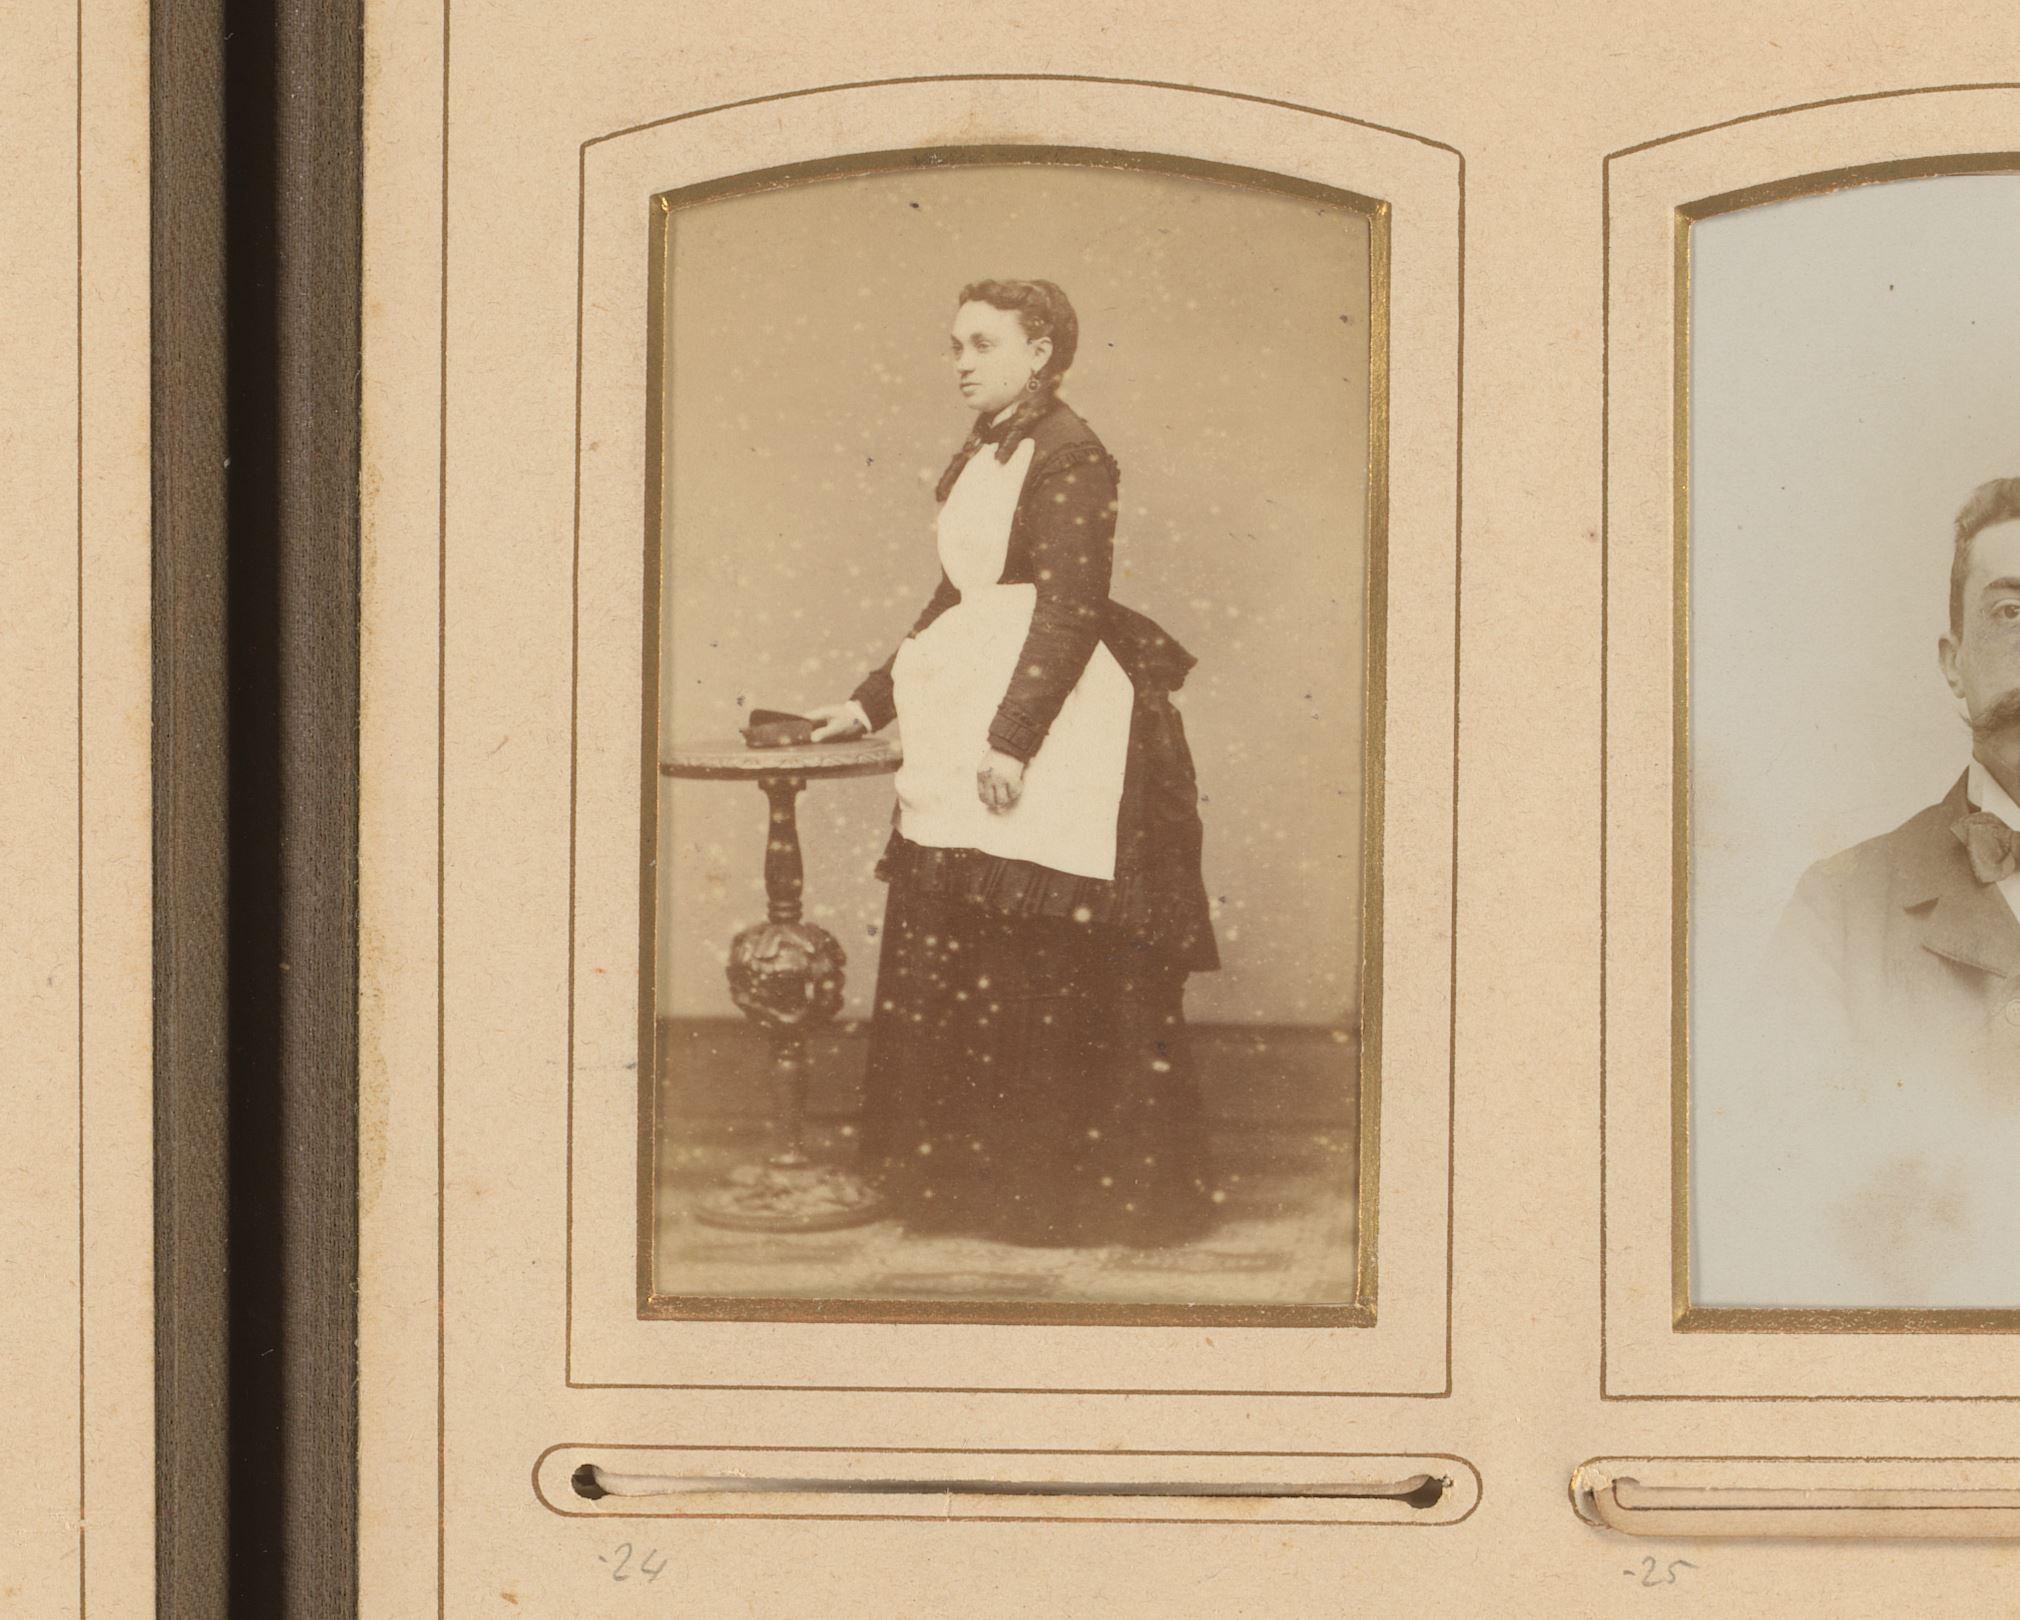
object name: album leaf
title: Portret van een onbekende vrouw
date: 1880-1884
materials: cardboard, paper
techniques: albumen print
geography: amsterdam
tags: anonymous historical person portrayed - bb - woman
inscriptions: address: ‘AMSTERDAM/ Rokin D. 88./ Kalverstraat D. 26./ UTRECHT/ Leijdschestraatweg L.153.’